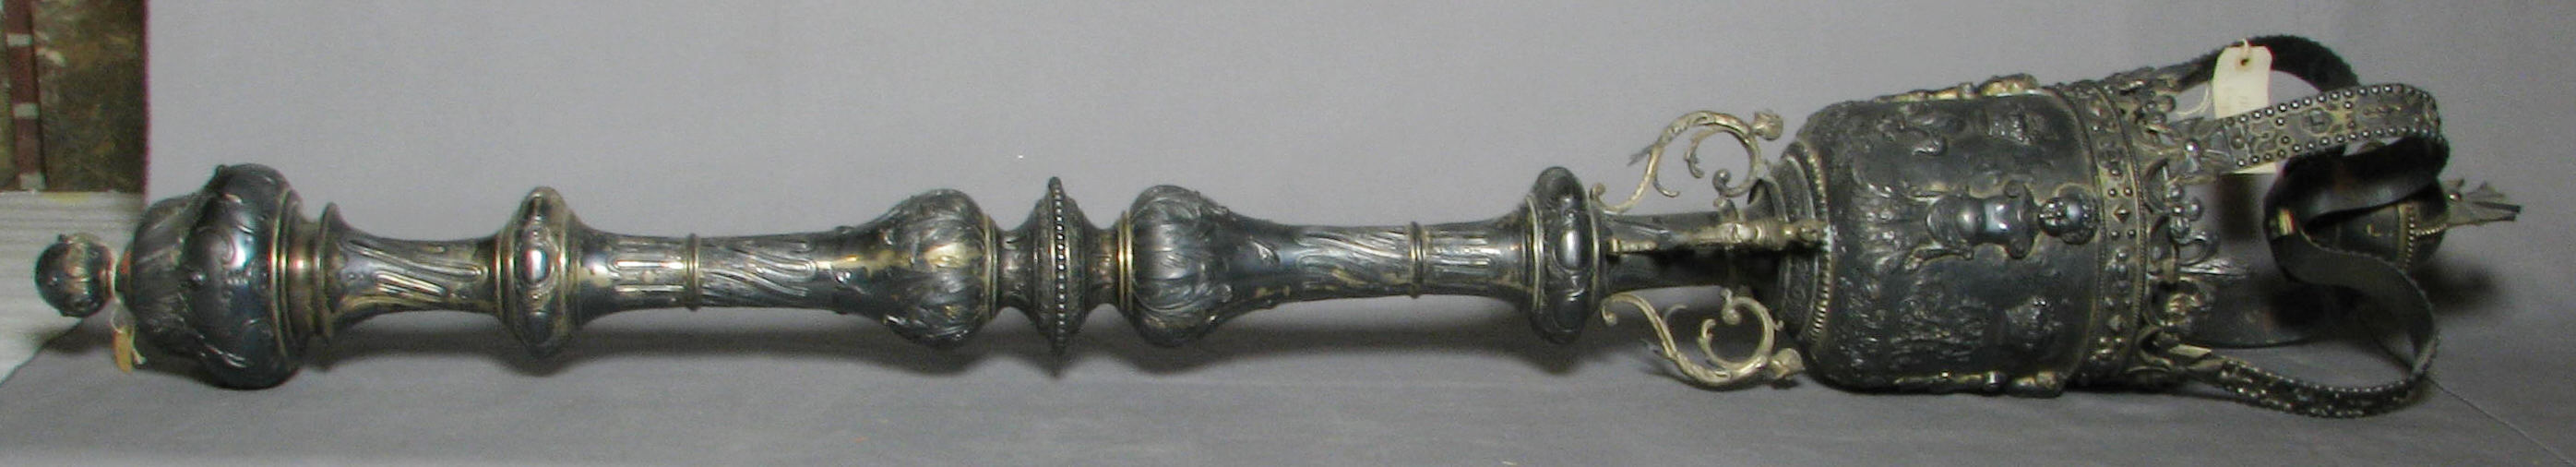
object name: mace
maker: john swift ii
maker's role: maker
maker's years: 1696-1796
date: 1801-1900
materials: metal, silver